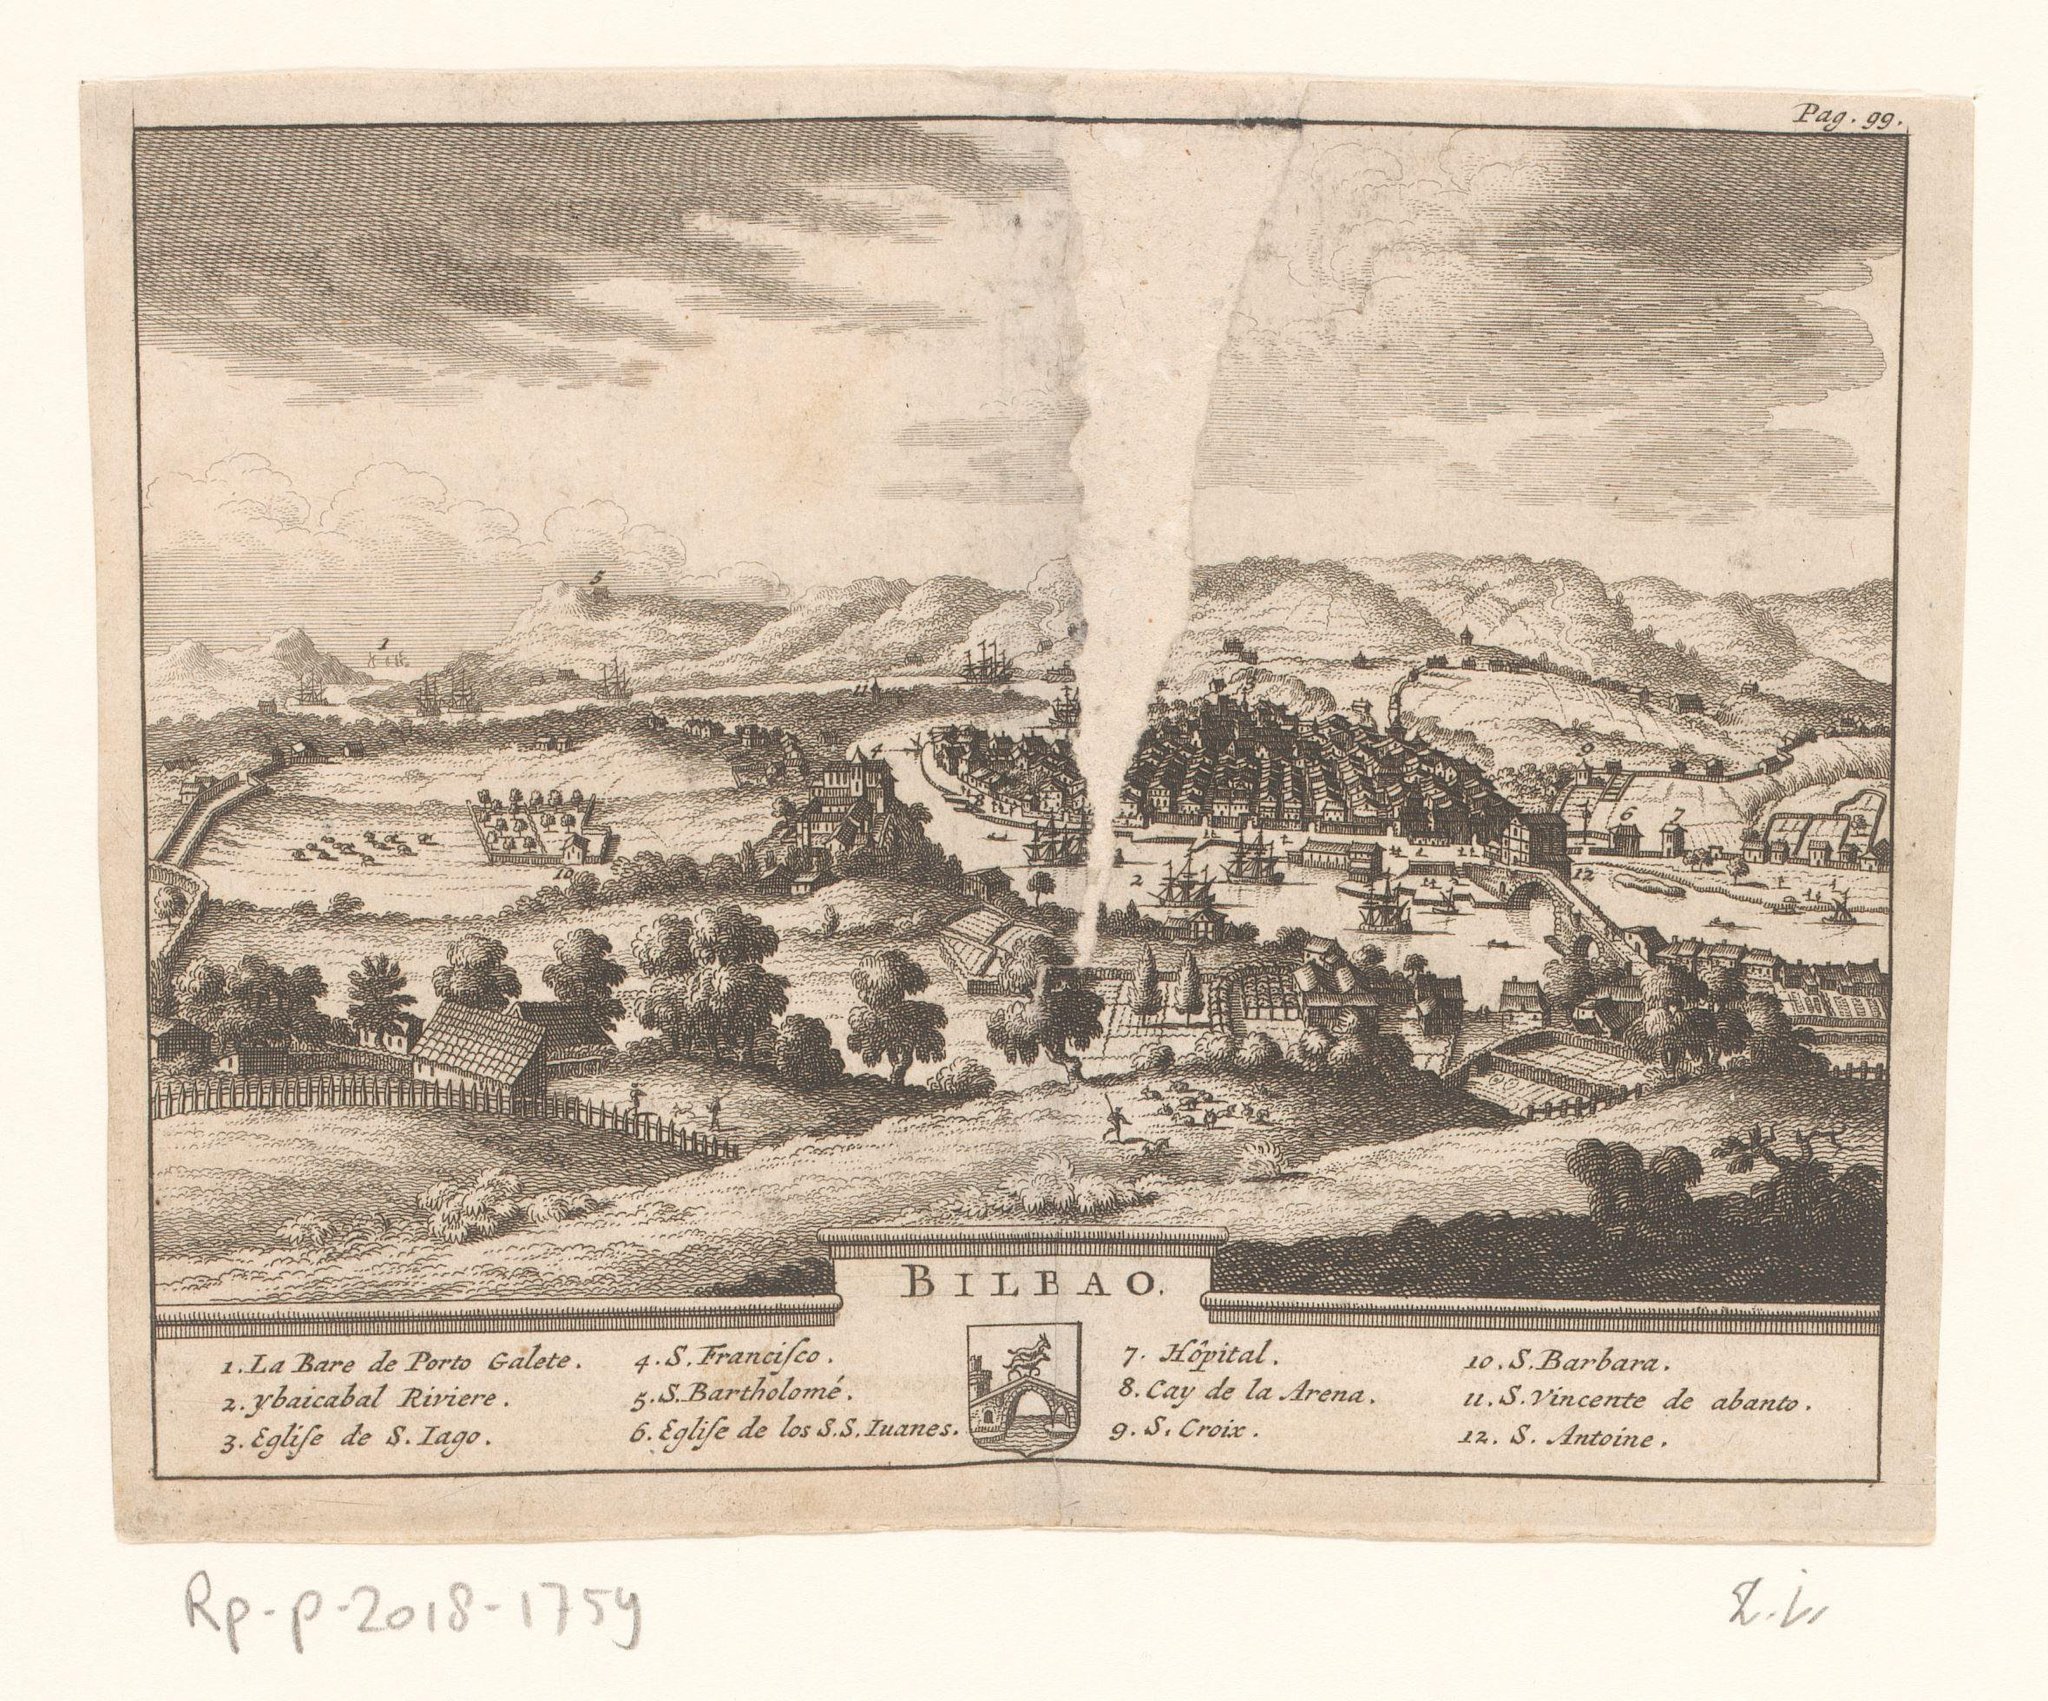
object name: print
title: Bilbao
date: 1726-1728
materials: paper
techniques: etching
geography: leiden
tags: coat of arms (as symbol of the state, etc.) (+ city; municipal), prospect of city, town panorama, silhouette of city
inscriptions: collector's mark: Lugt 2228